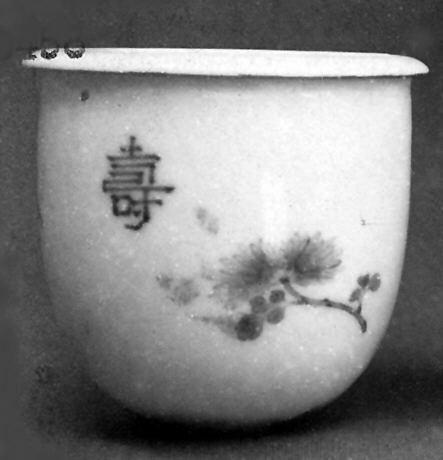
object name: wine cup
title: Nesting Wine Cup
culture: japanese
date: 1820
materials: glaze, porcelain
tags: flowers